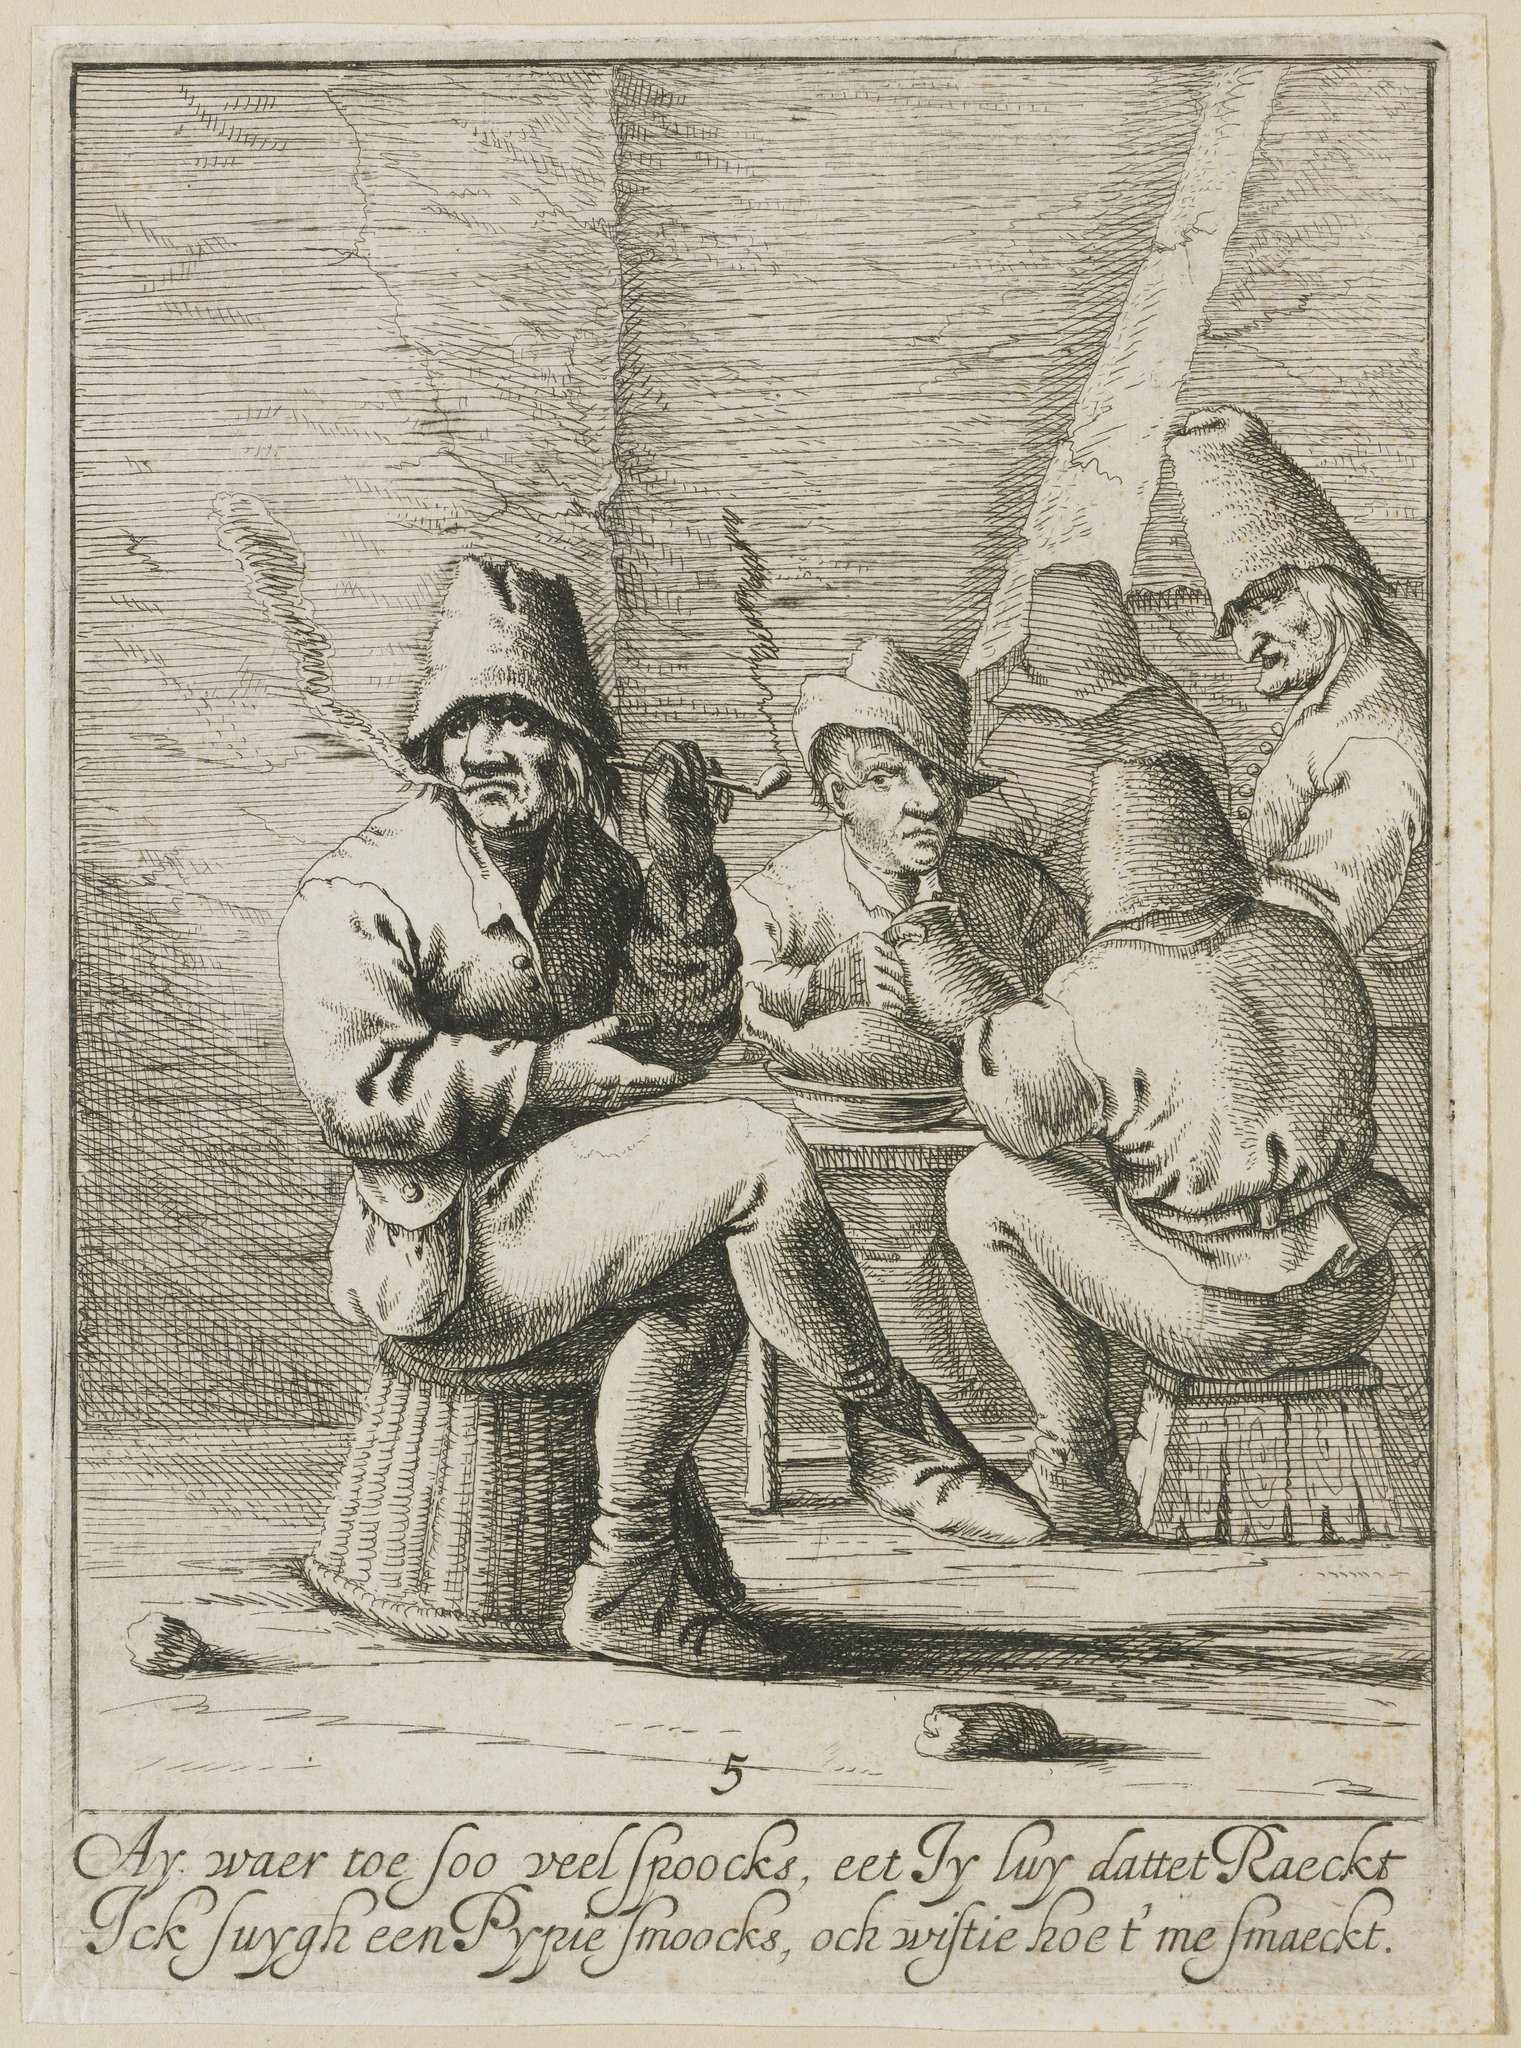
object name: print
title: Smaak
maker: isaac vos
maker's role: publisher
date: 1600-1670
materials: paper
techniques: etching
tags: taste, tasting (one of the five senses), pipe ~ tobacco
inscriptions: collector's mark: Lugt 240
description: Een man rookt in een herberg een pijp. Hij zit op een omgekeerde mand met de benen over elkaar geslagen. Op de achtergrond vier figuren. Onder de voorstelling een tweeregelig vers in het Nederlands. De prent maakt deel uit van een serie van vijf prenten met de vijf zintuigen.